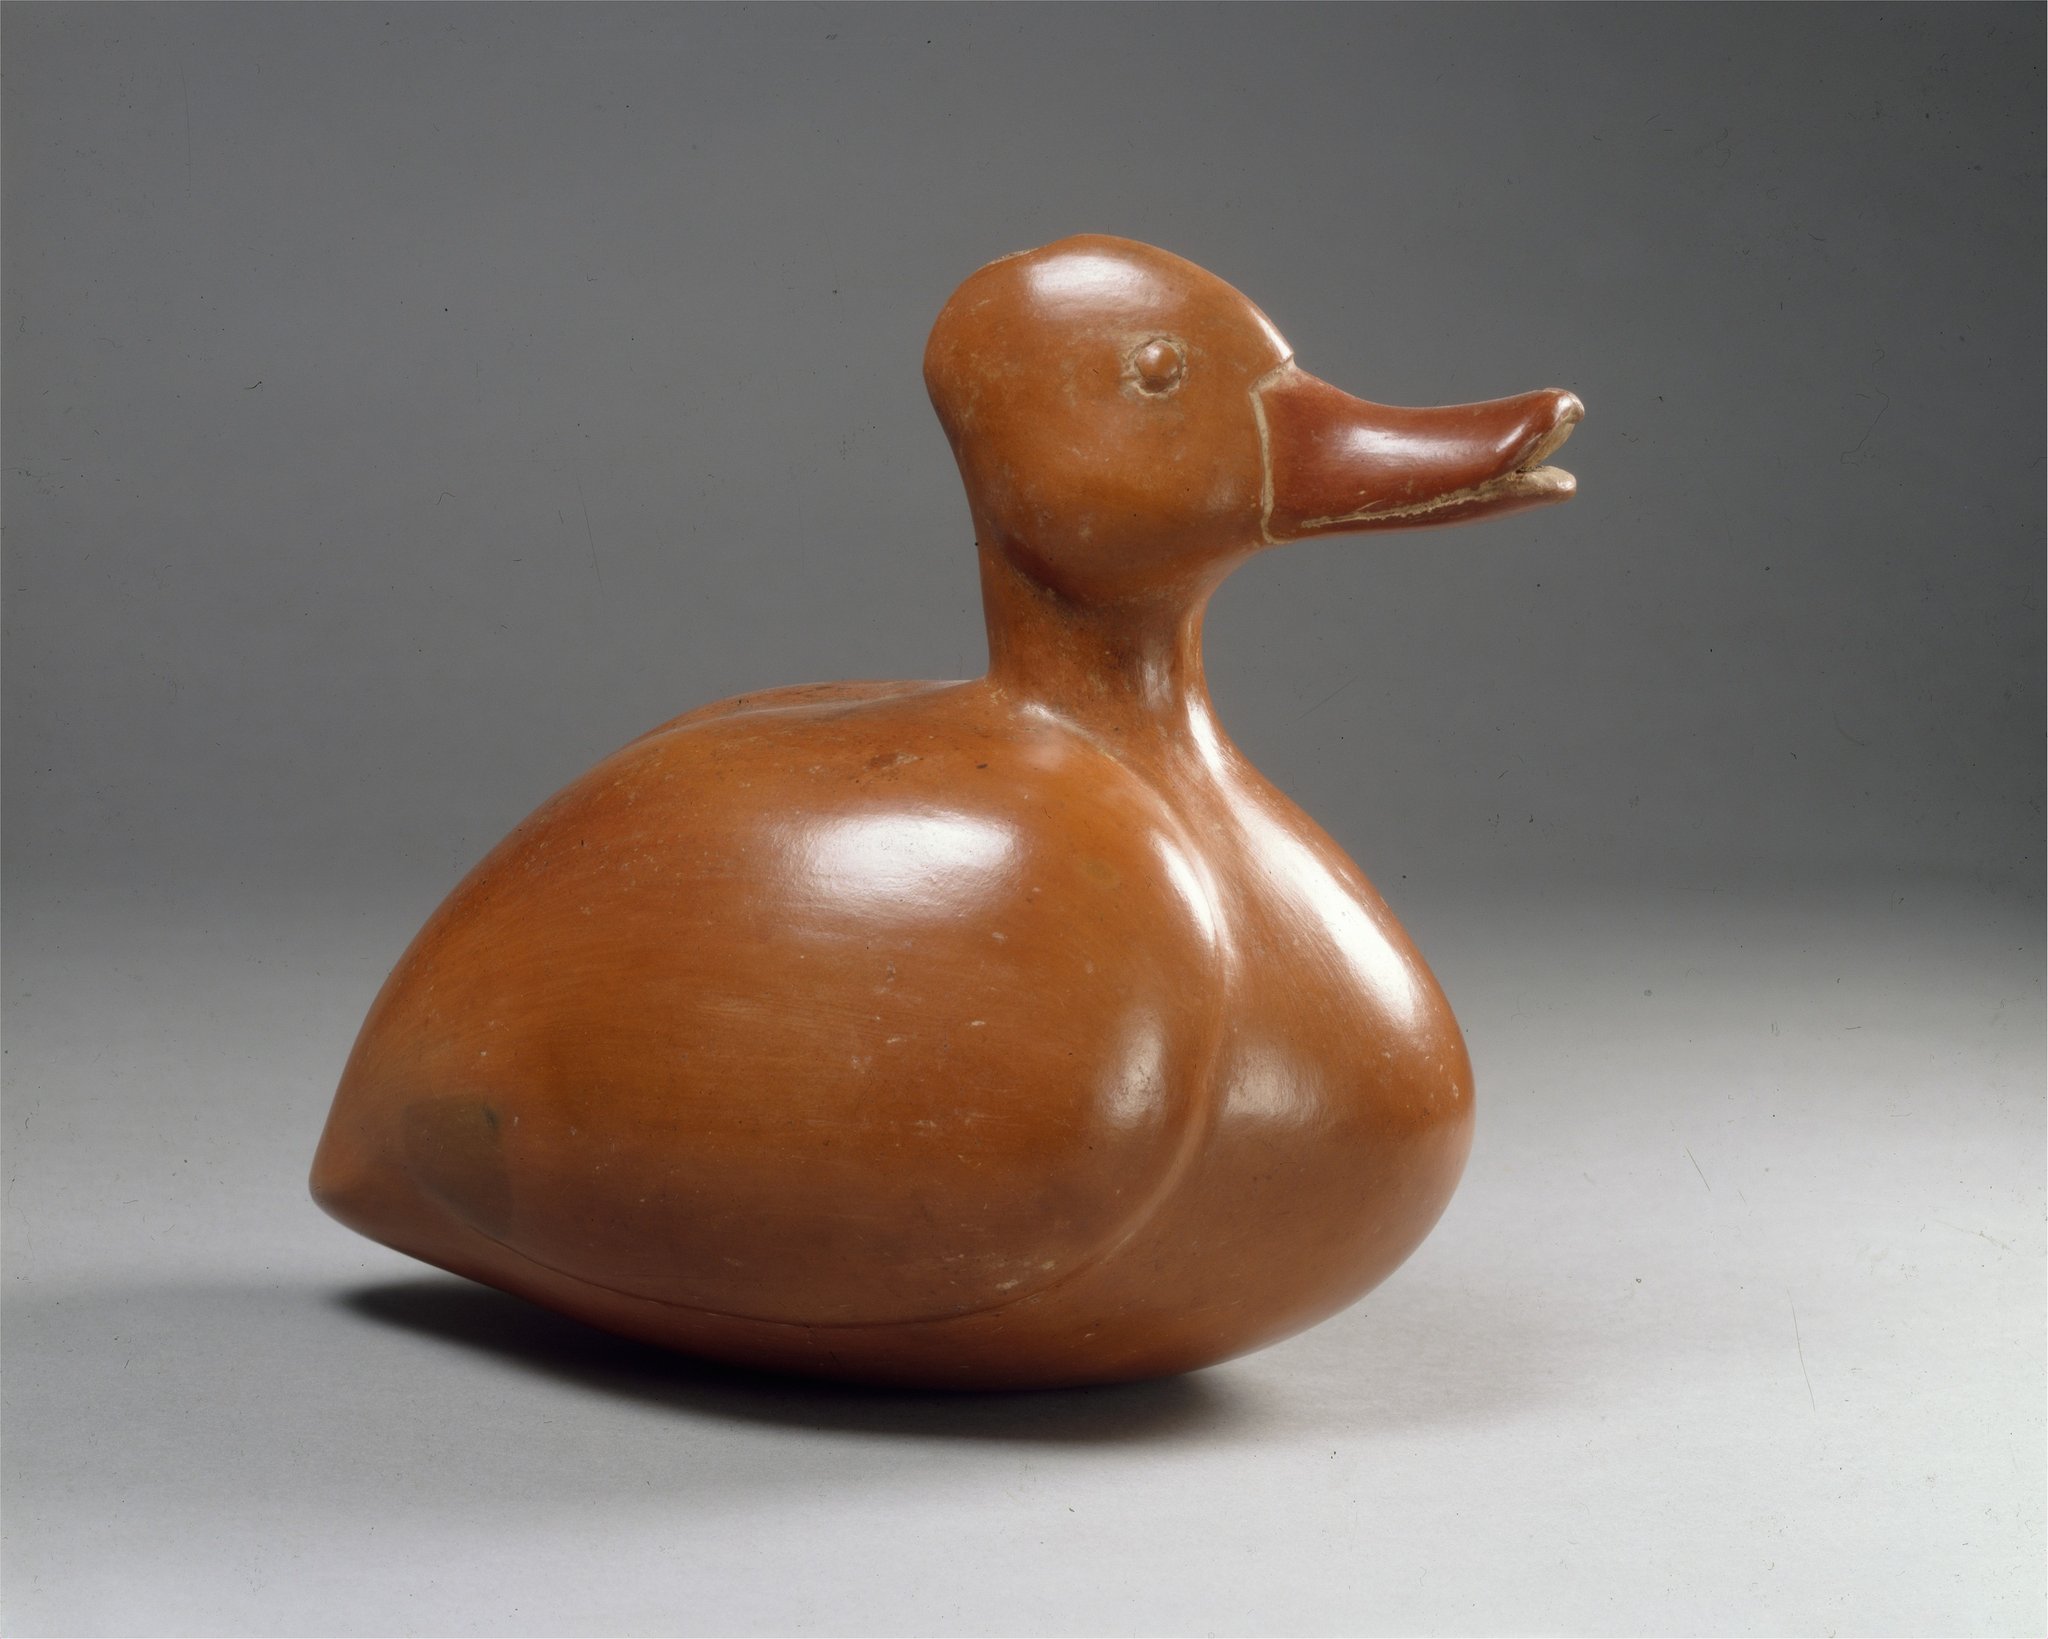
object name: duck figure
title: Duck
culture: comala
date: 200 BCE-300 CE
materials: ceramic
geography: mexico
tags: ducks